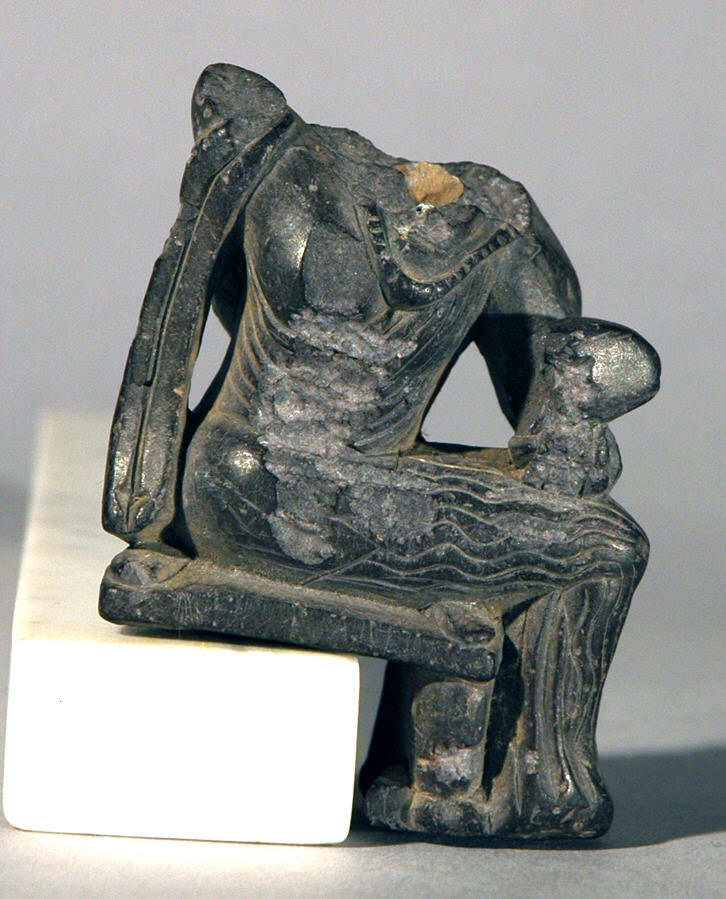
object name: mirror handle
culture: kashmiri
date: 501-800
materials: stone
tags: kashmir,women